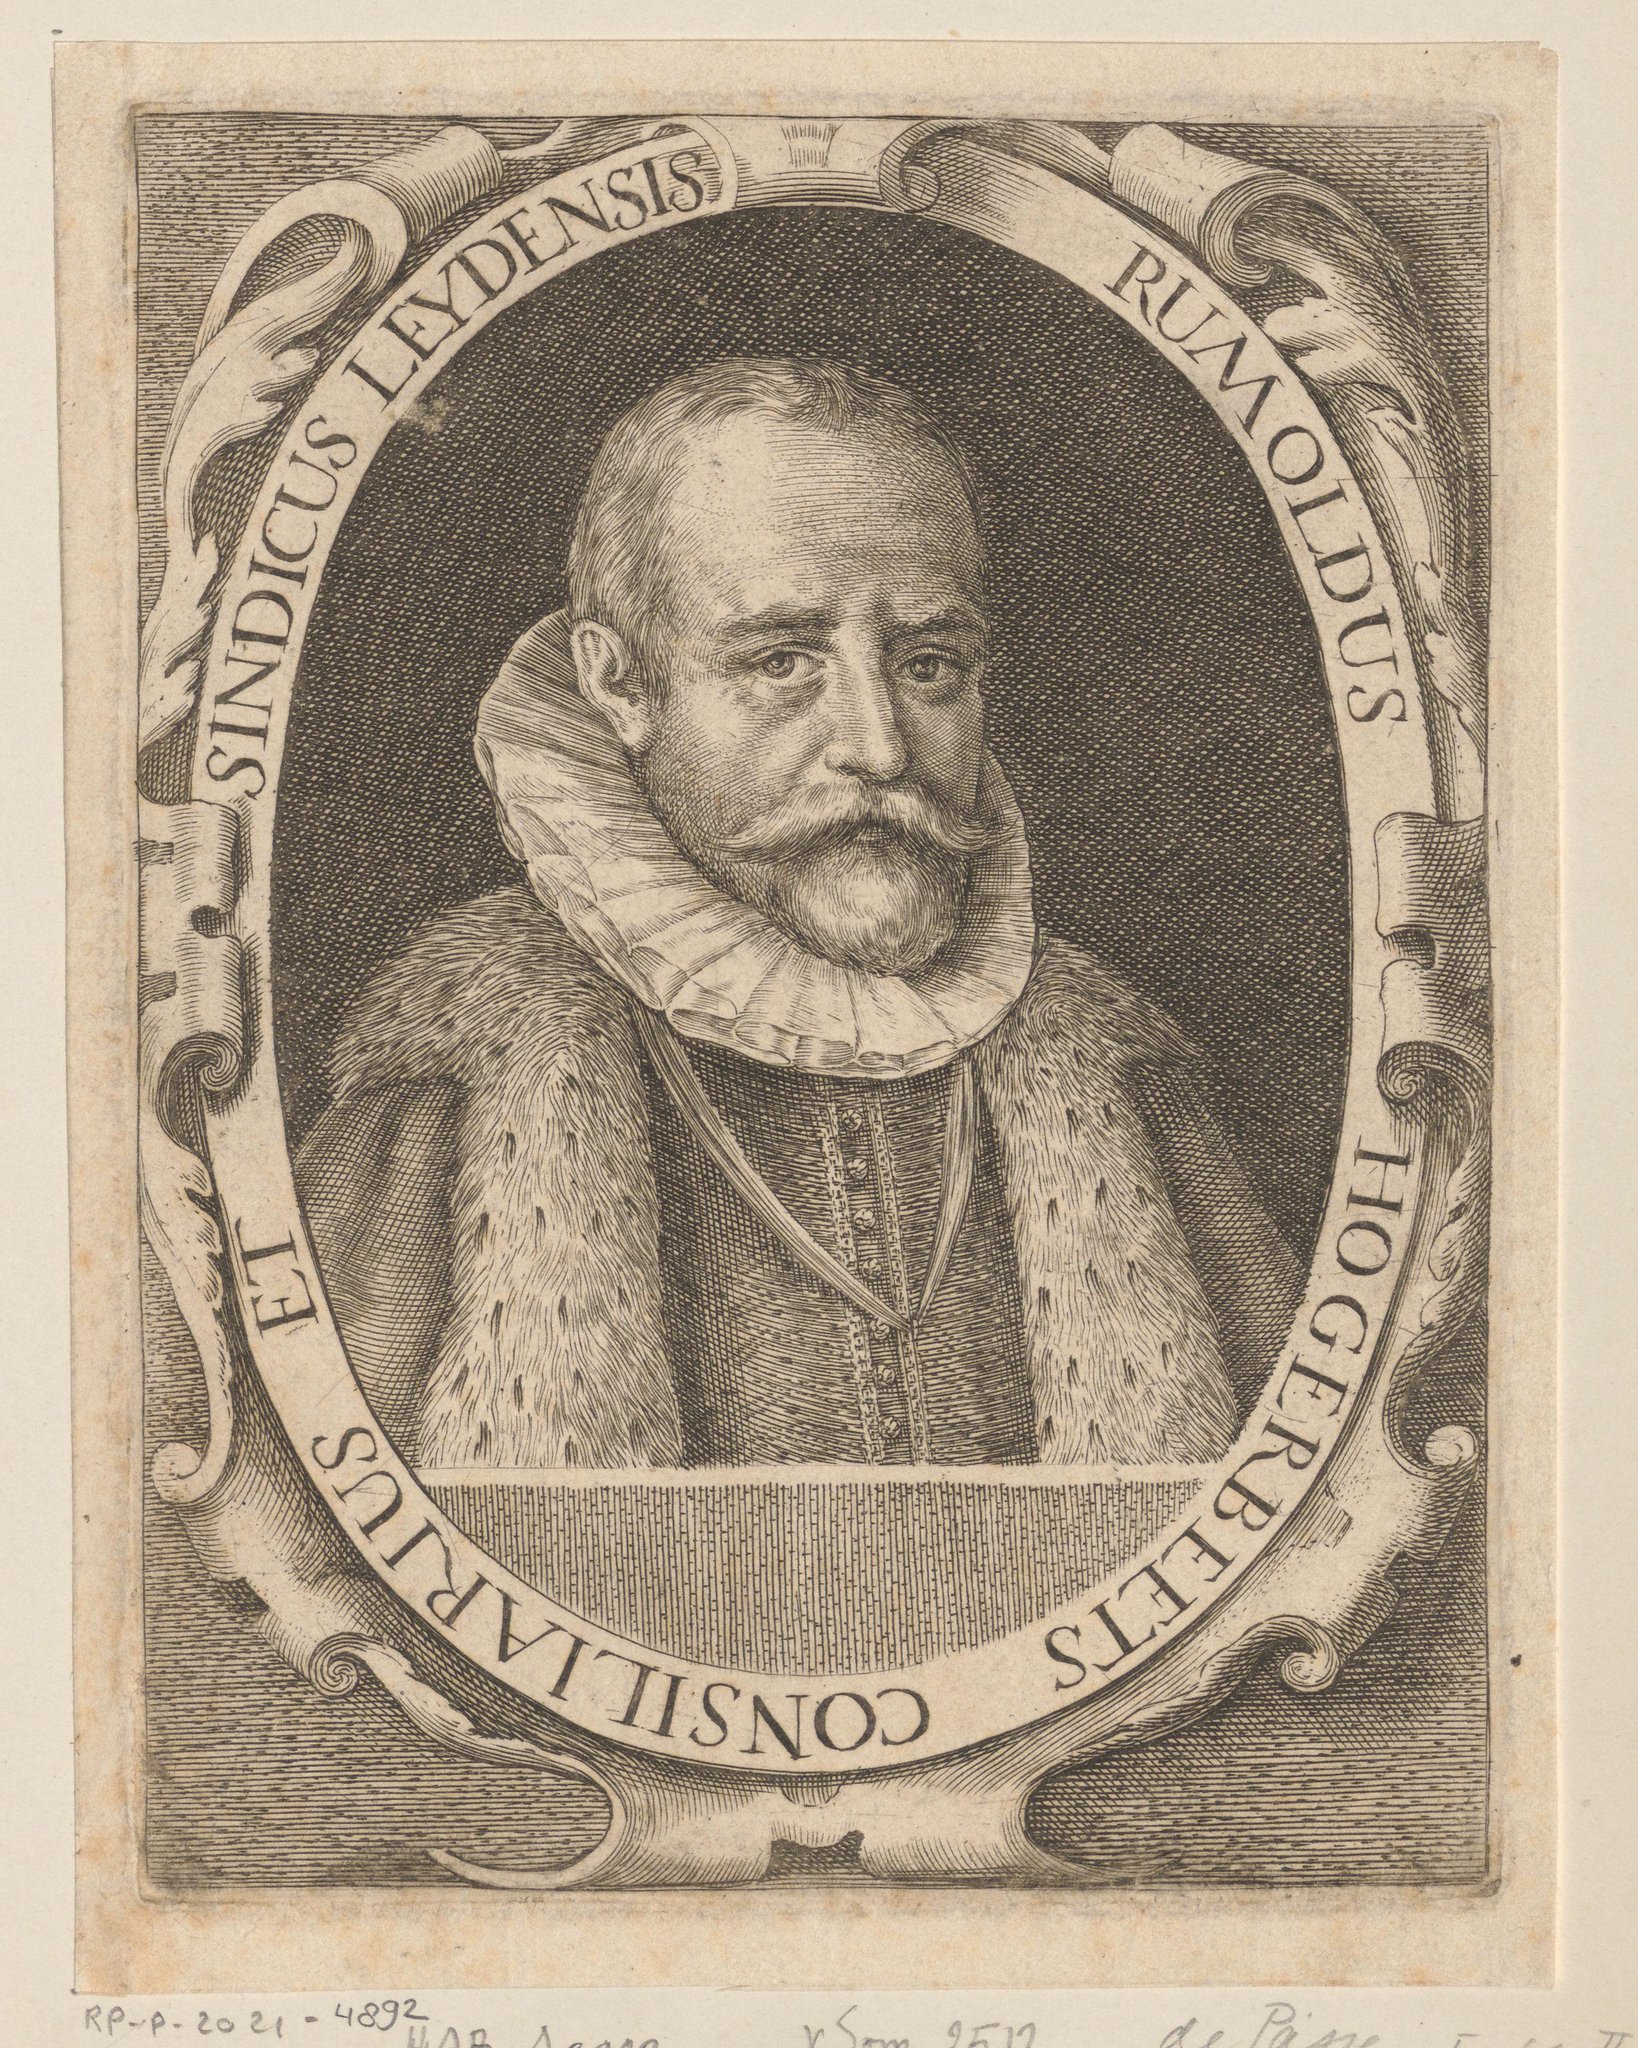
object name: print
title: Portret van Rombout Hogerbeets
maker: crispijn van de passe (i)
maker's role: draughtsman, print maker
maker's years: 1564-1637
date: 1590-1637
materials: paper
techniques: engraving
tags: hoorn (north holland), historical persons